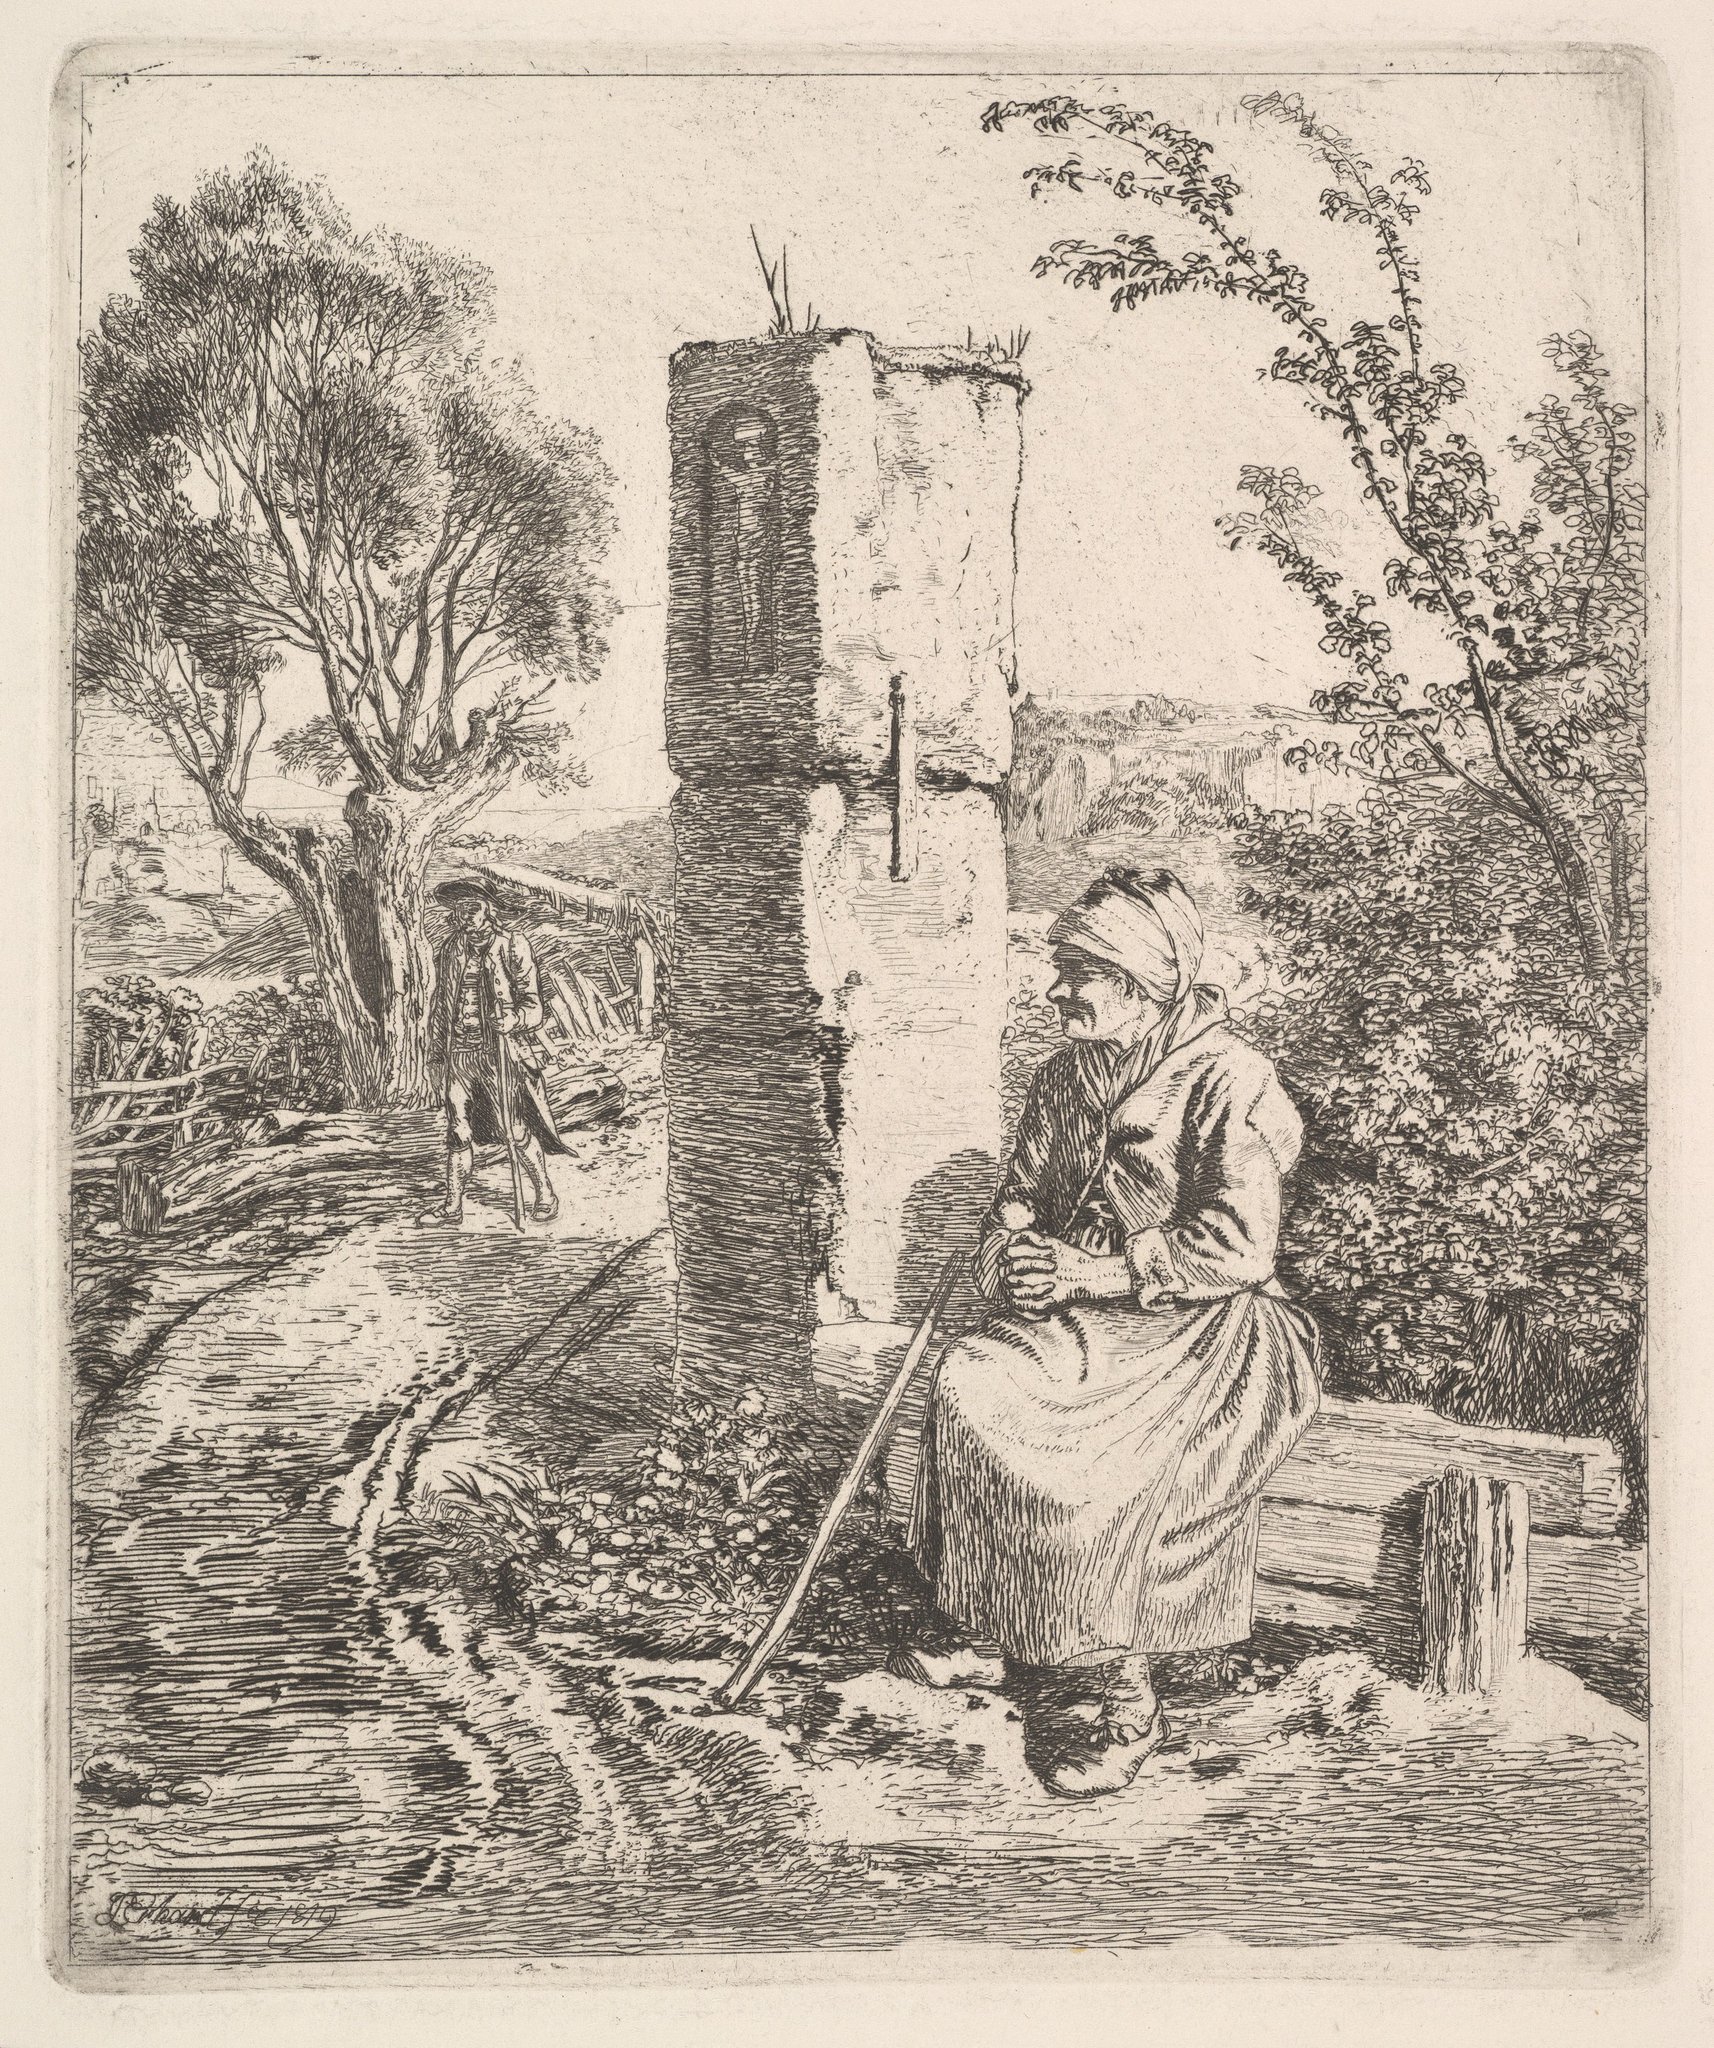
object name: print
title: An Old Lady Sitting Near a Pillar at Side of Road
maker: johann christoph erhard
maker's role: artist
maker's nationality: german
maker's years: 1795-1822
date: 1819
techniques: etching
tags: monuments,roads,men,women